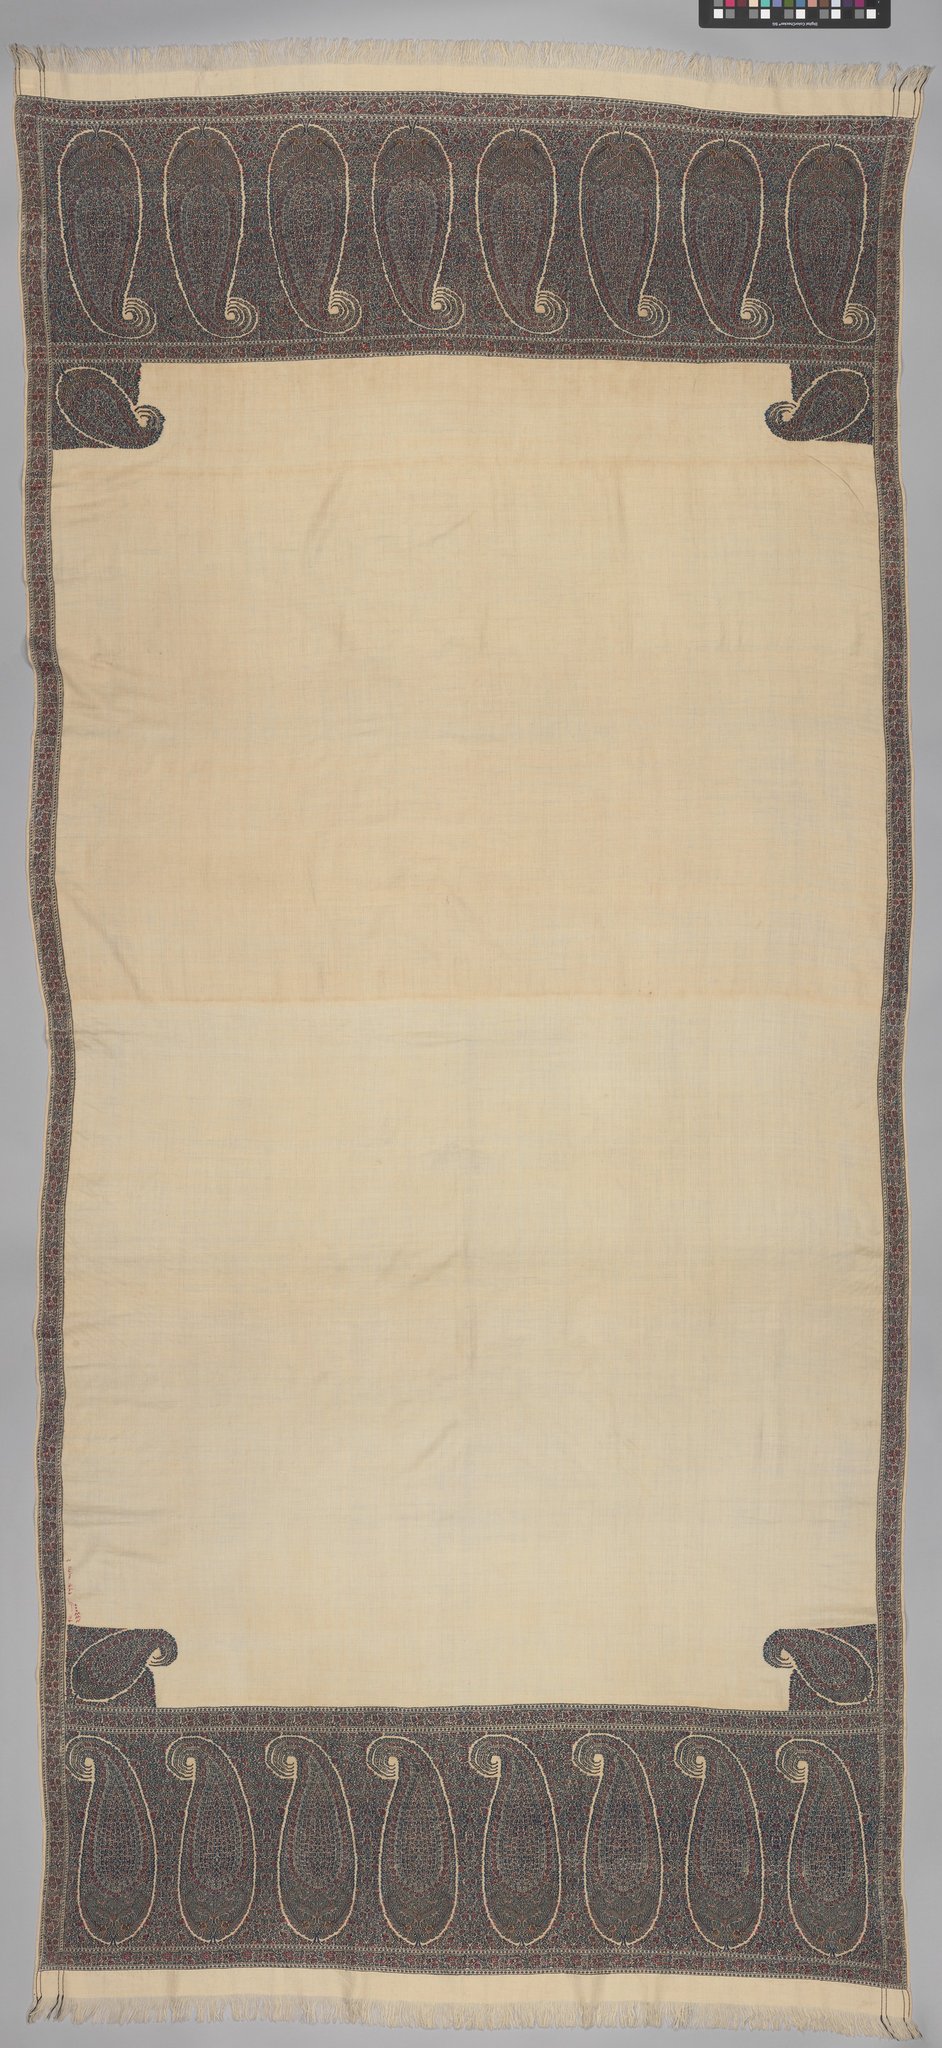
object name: shawl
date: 1826-1850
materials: wool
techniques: interlocking, weave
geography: india